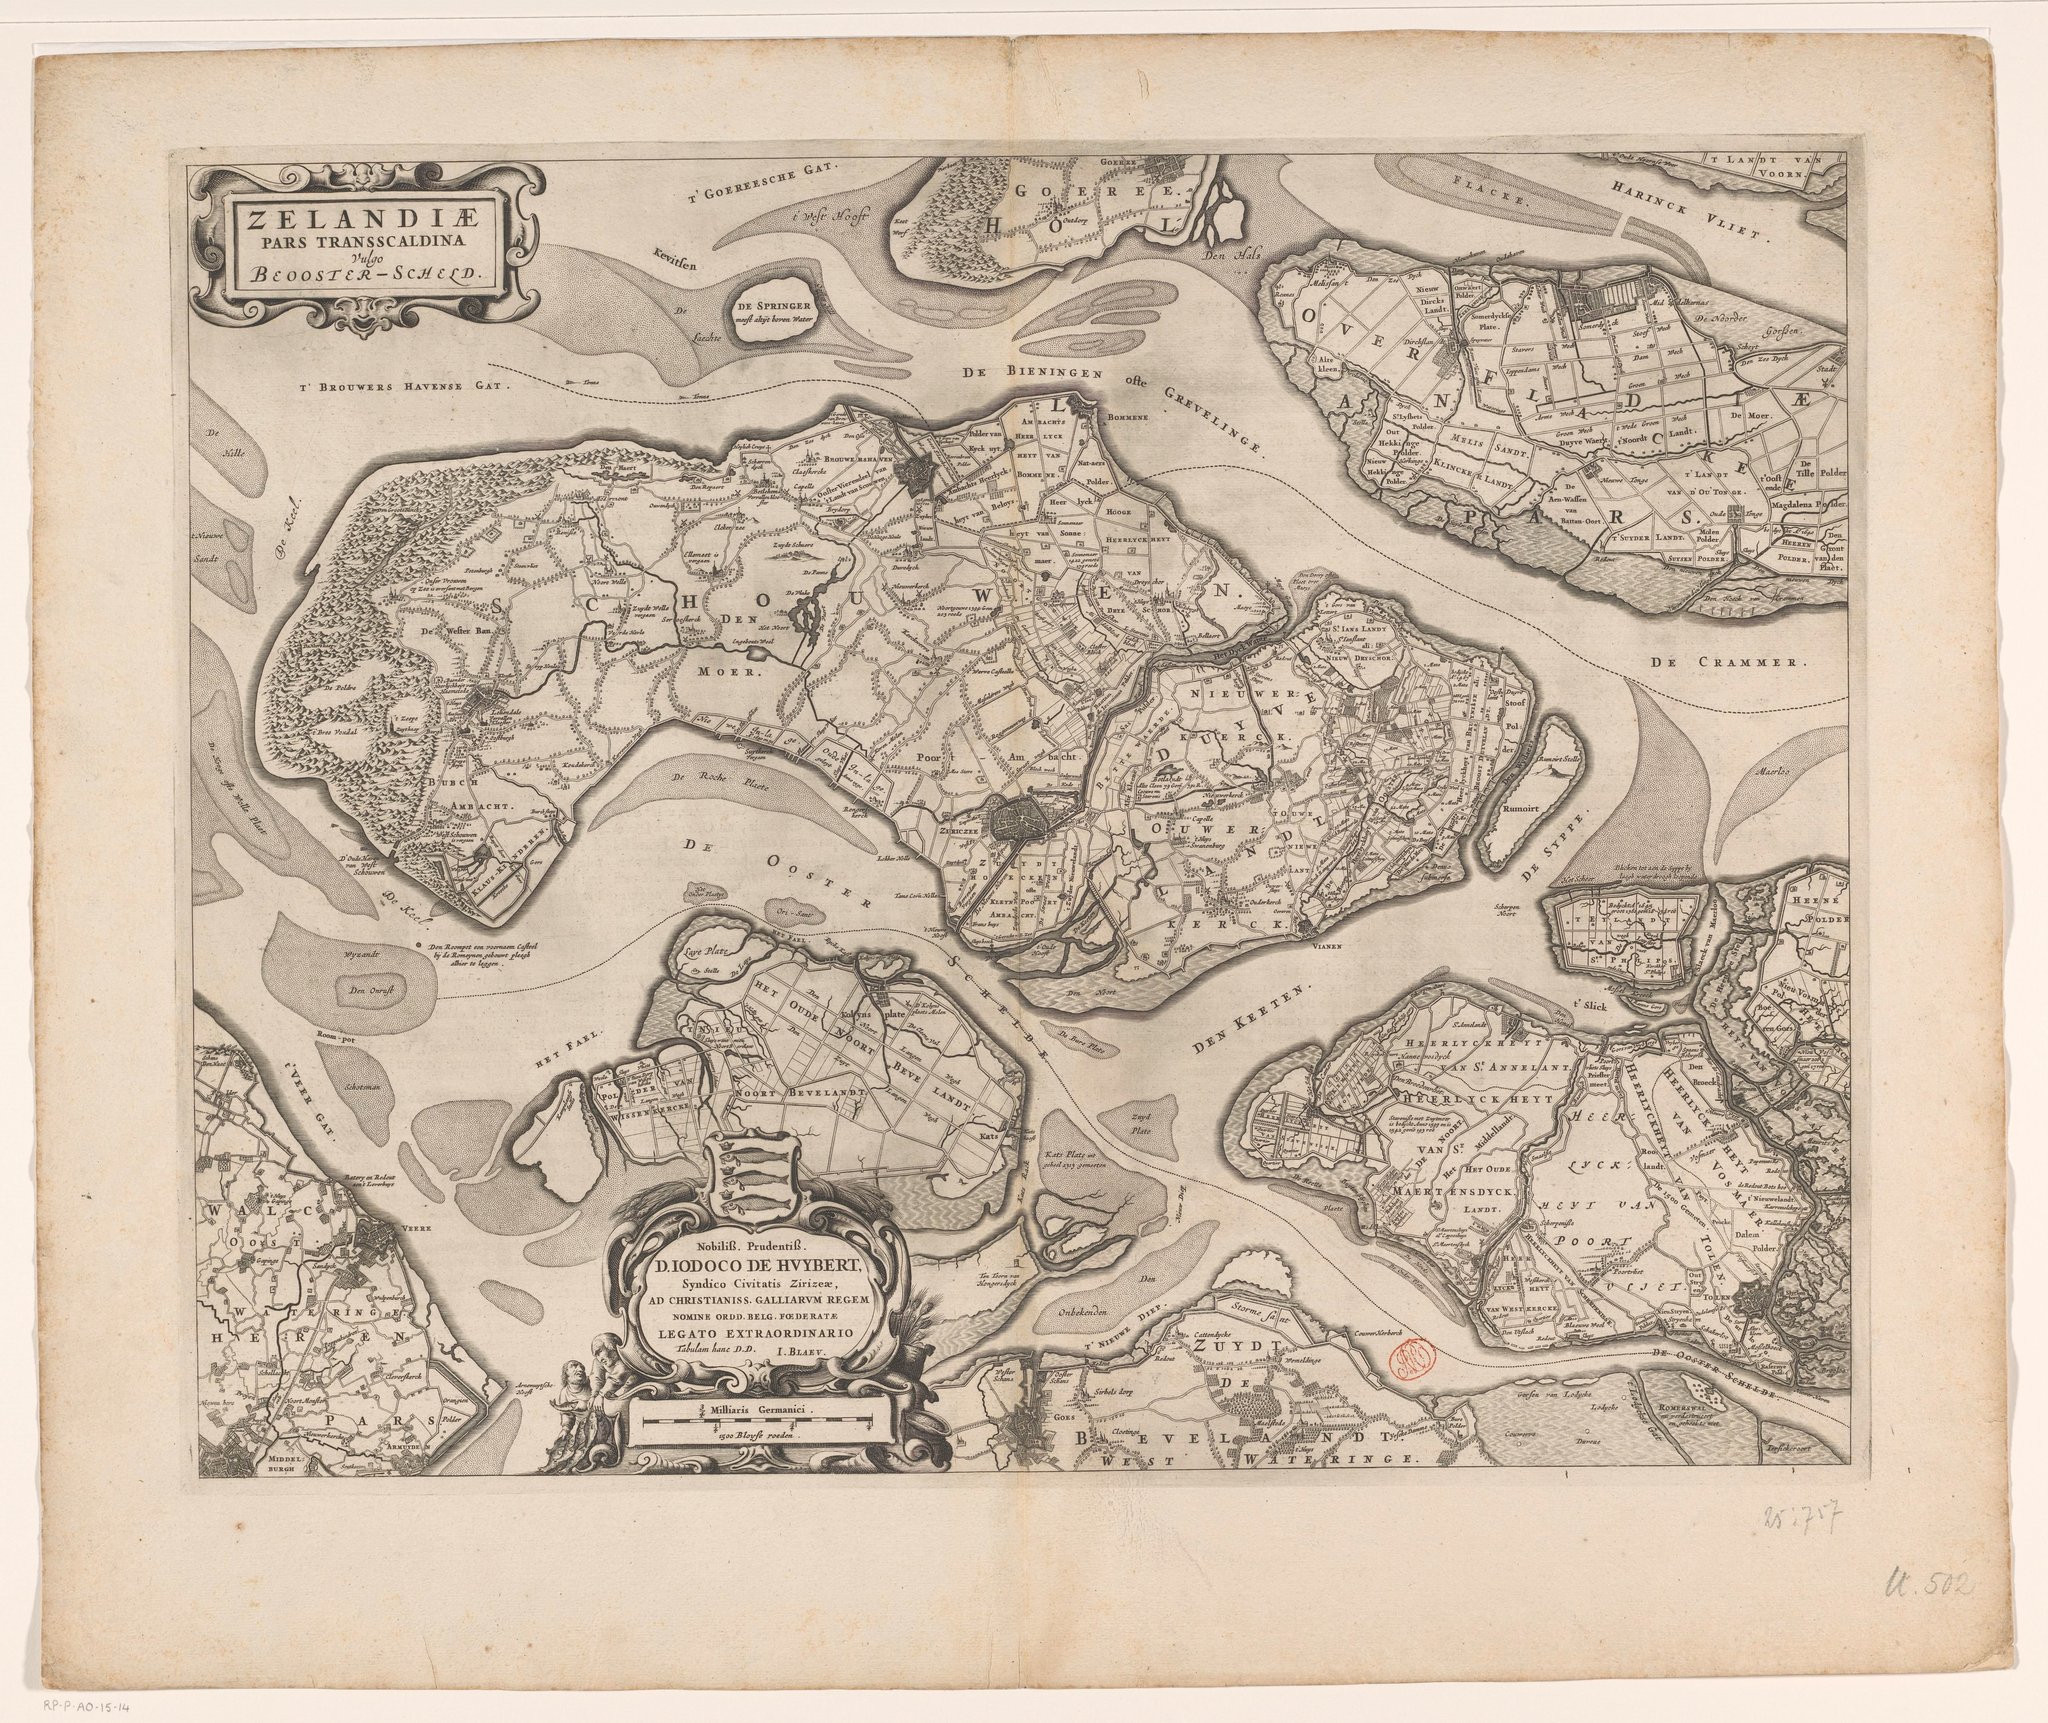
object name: print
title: Kaart van Schouwen-Duiveland en Tholen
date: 1662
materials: paper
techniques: engraving, etching, letterpress printing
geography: amsterdam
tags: maps of separate countries or regions, zeeland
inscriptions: collector's mark: Lugt 195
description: Schouwen-Duiveland en Tholen, de Zeeuwse eilanden ten oosten van de Oosterschelde, staan centraal op deze kaart. Linksboven de titelcartouche. Onder, links van het midden, een cartouche met het wapen van en de opdracht aan Justus (Jodocus) de Huybert en een schaalstok: 3/4 Milliaris Germanici / 1500 Bloyse roeden. Op verso Latijnse tekst.